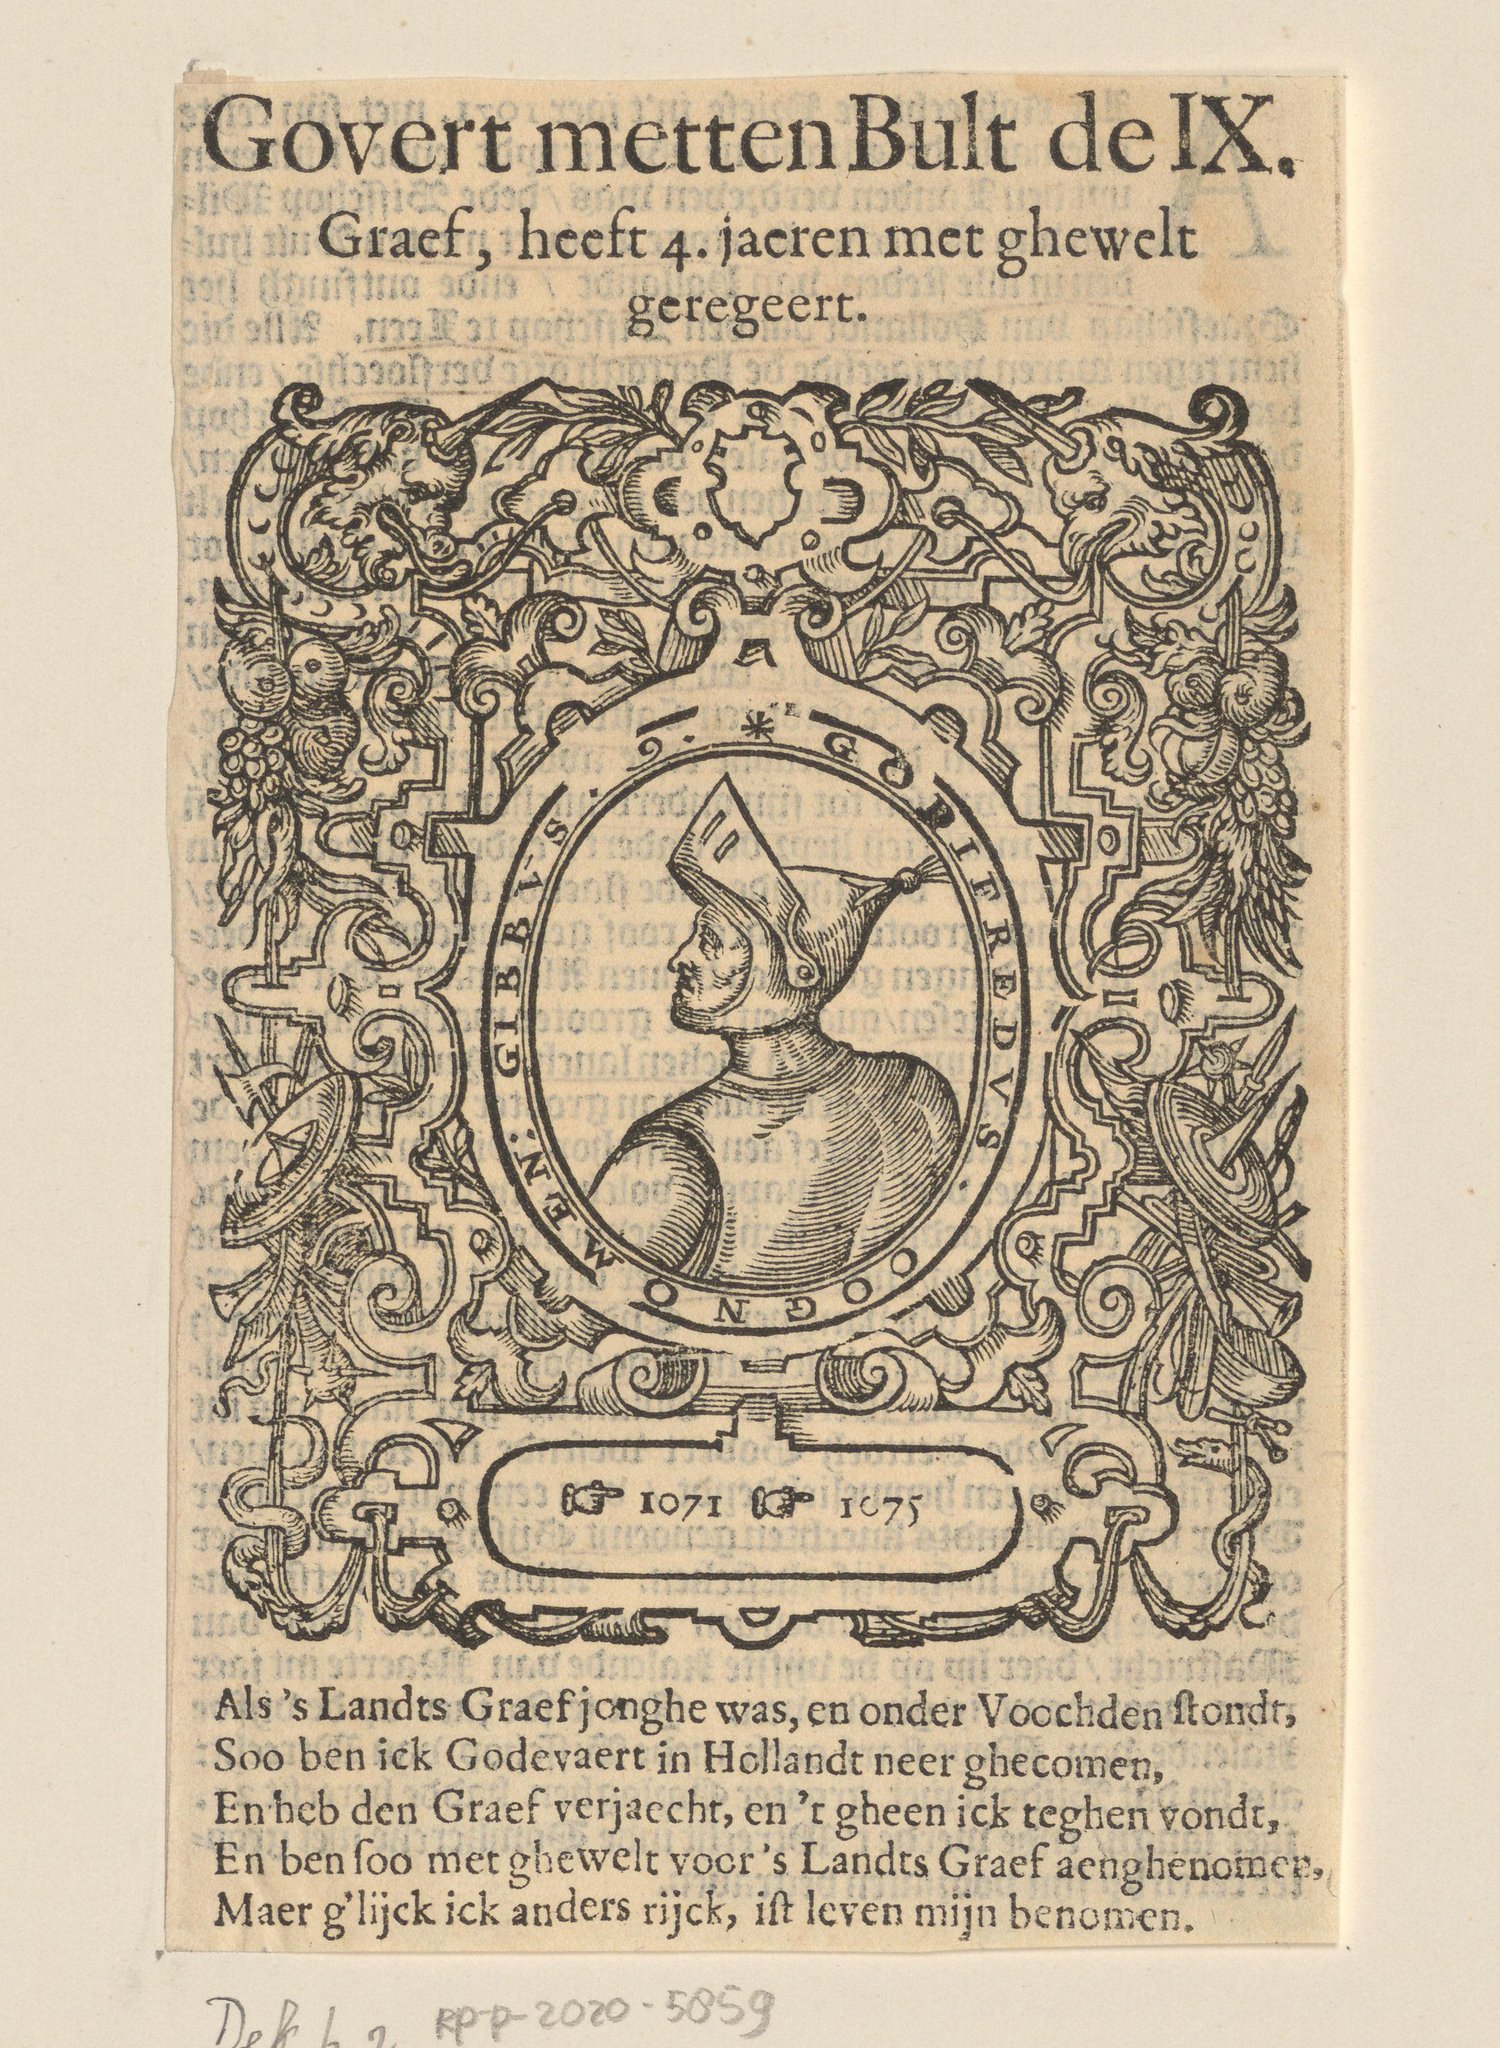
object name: book illustration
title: Portret van Godfried van Lotharingen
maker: Anonymous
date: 1612-1700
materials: paper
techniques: letterpress printing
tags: commander-in-chief, general, marshal, historical persons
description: Prent uit een onbekende editie van: Schrijver, Peter. Beschrijvinghe van Out Batavien, mitsgaders d'Afkomst ende historie der graven van Holland, Zeeland ende Vrieslandt. S.l.s.n., 1612.